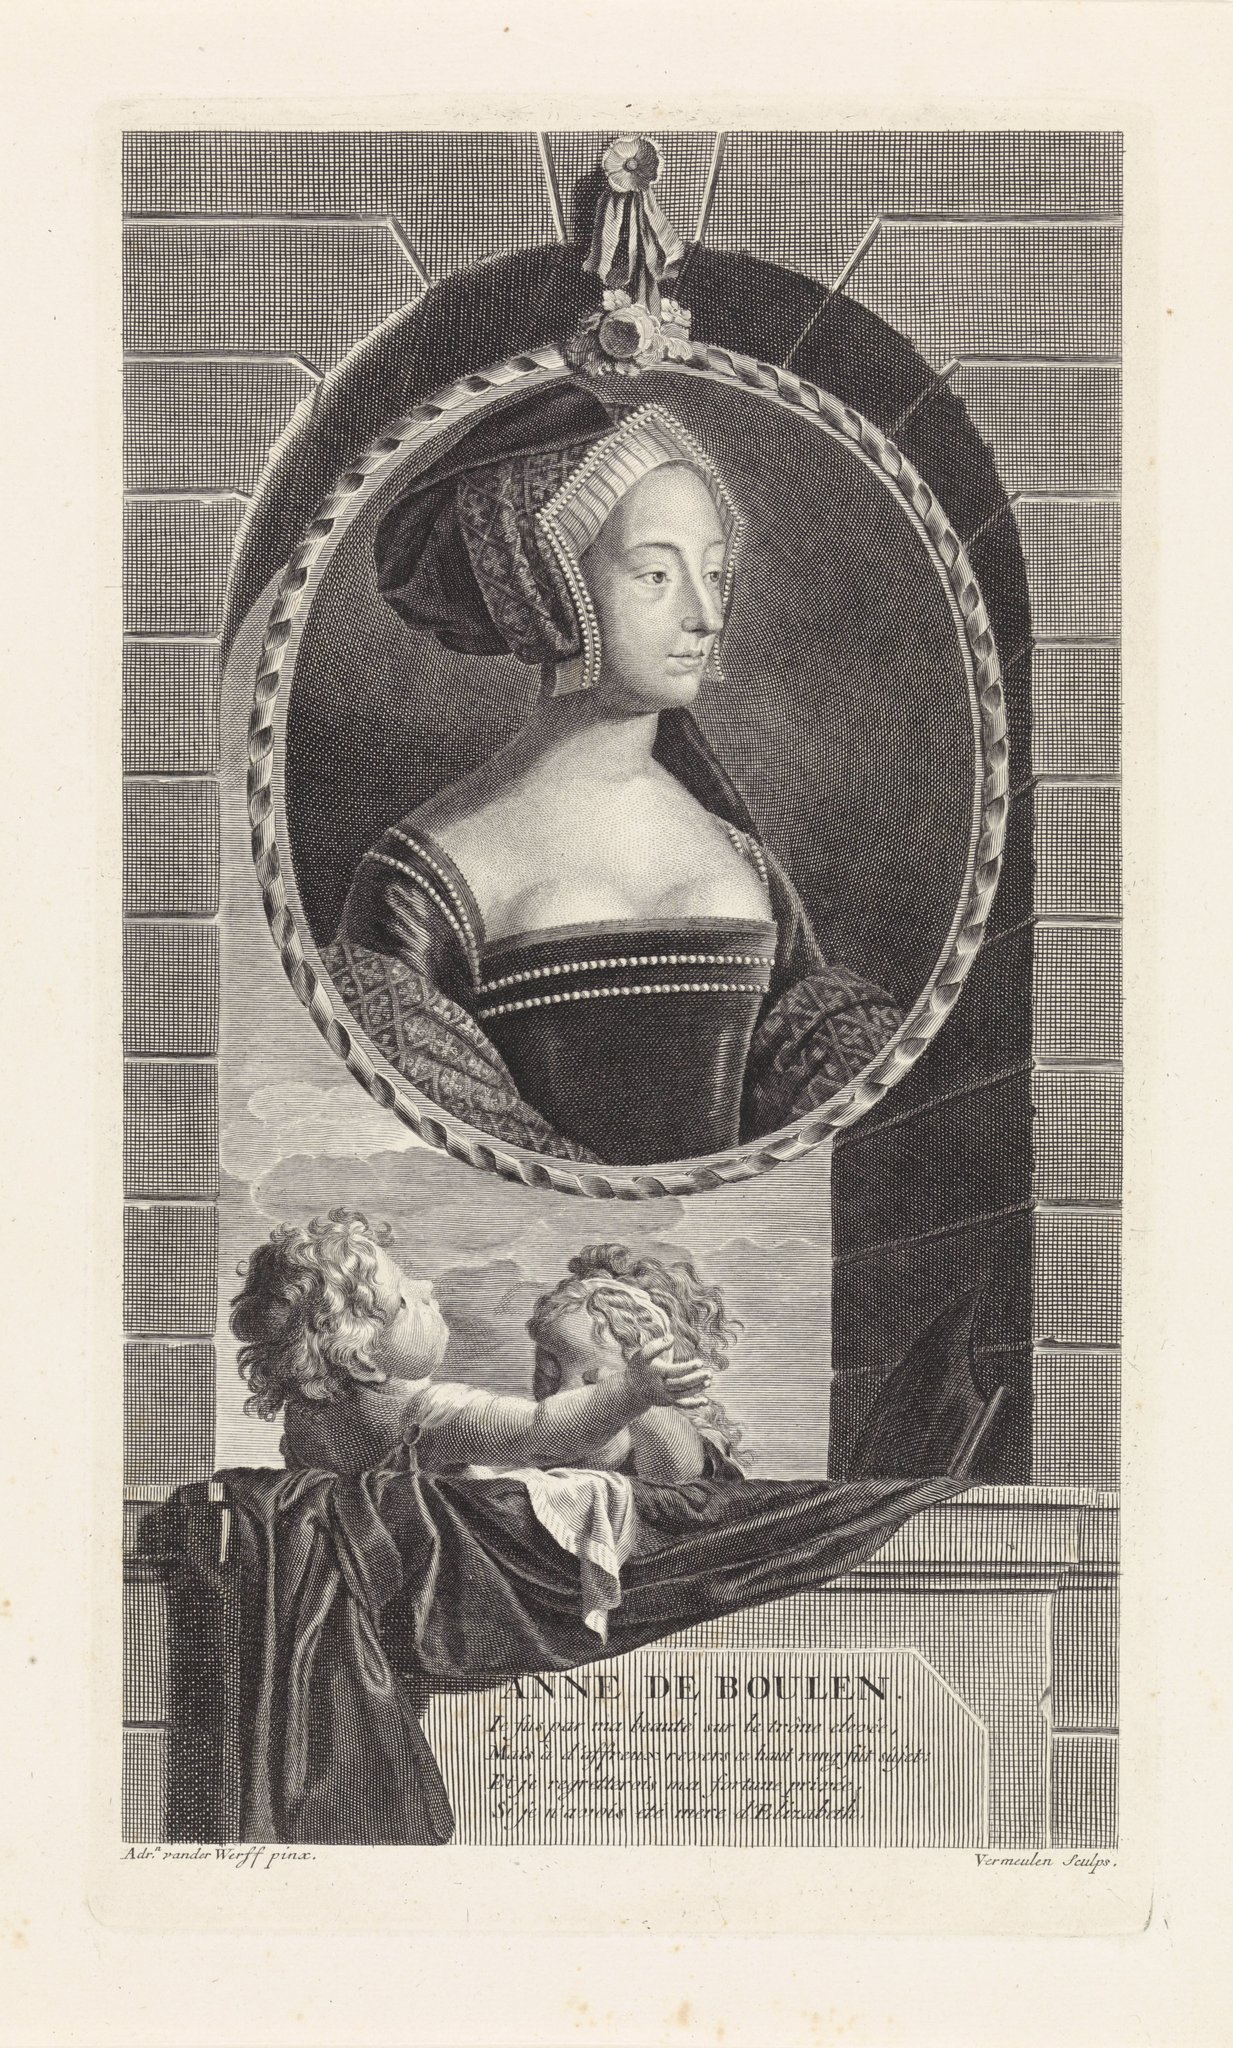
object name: print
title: Elf portretten uit de Engelse geschiedenis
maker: adriaen van der werff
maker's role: draughtsman, painter, print maker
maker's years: 1659-1722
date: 1697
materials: paper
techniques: engraving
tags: london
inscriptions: collector's mark: Lugt 2228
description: Prent ook gebruikt als boekillustratie in: Larrey, Isaac de. Histoire d'Angleterre, d'Ecosse, et d'Irlande. 4 dln. Rotterdam: Reinier Leers, 1697-1713.